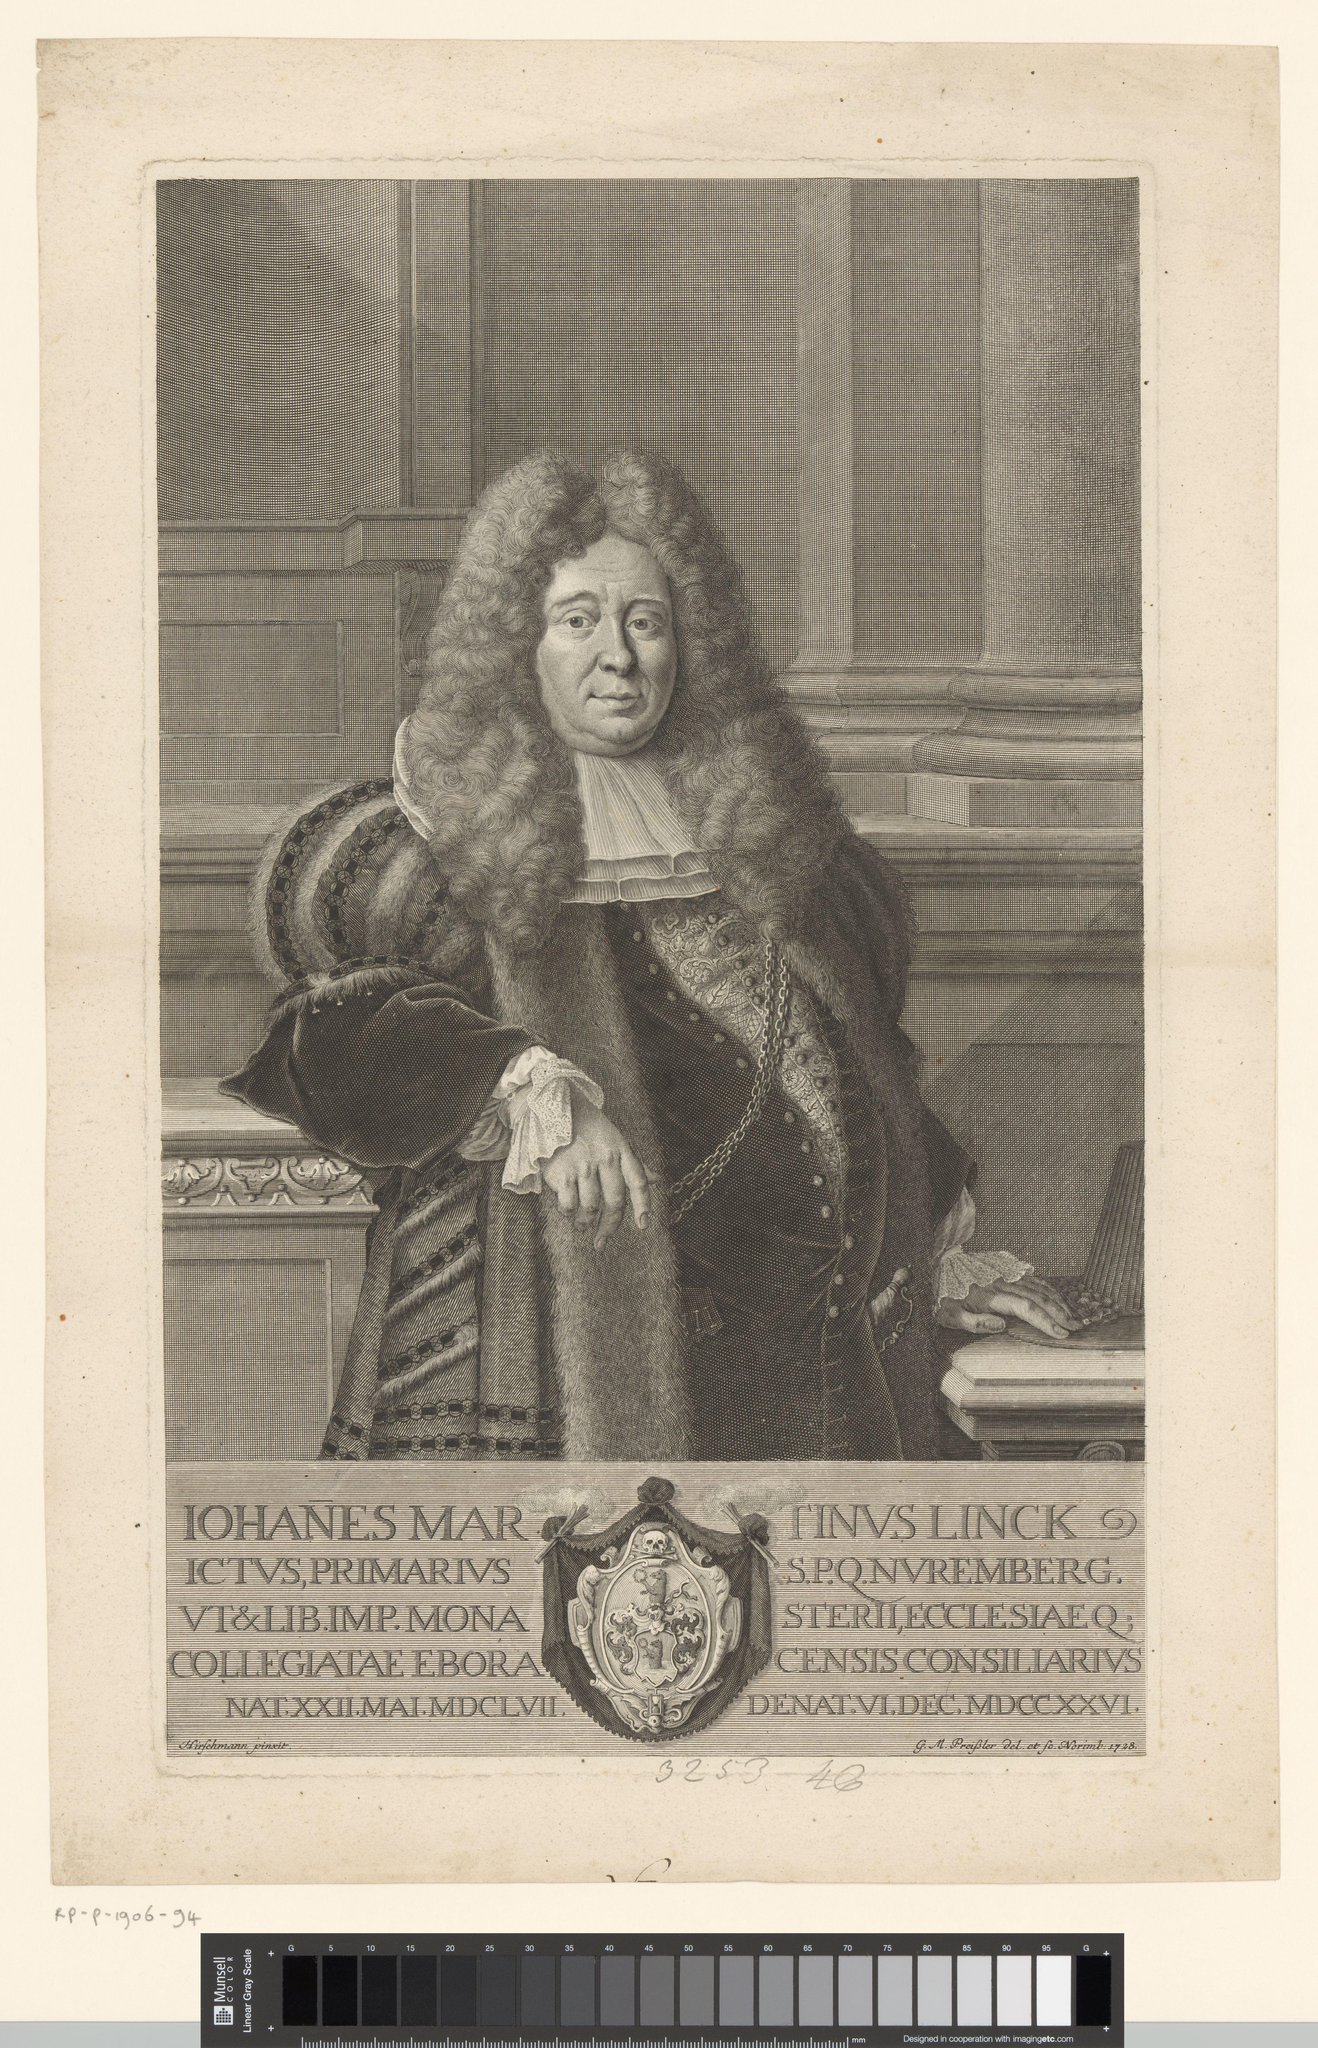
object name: print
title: Portret van Johann Heinrich Linck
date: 1728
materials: paper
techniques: engraving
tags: other non-personal regalia, e.g. mayor chain, historical persons, armorial bearing, heraldry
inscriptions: collector's mark: Lugt 2228, number: ‘3253 4c’